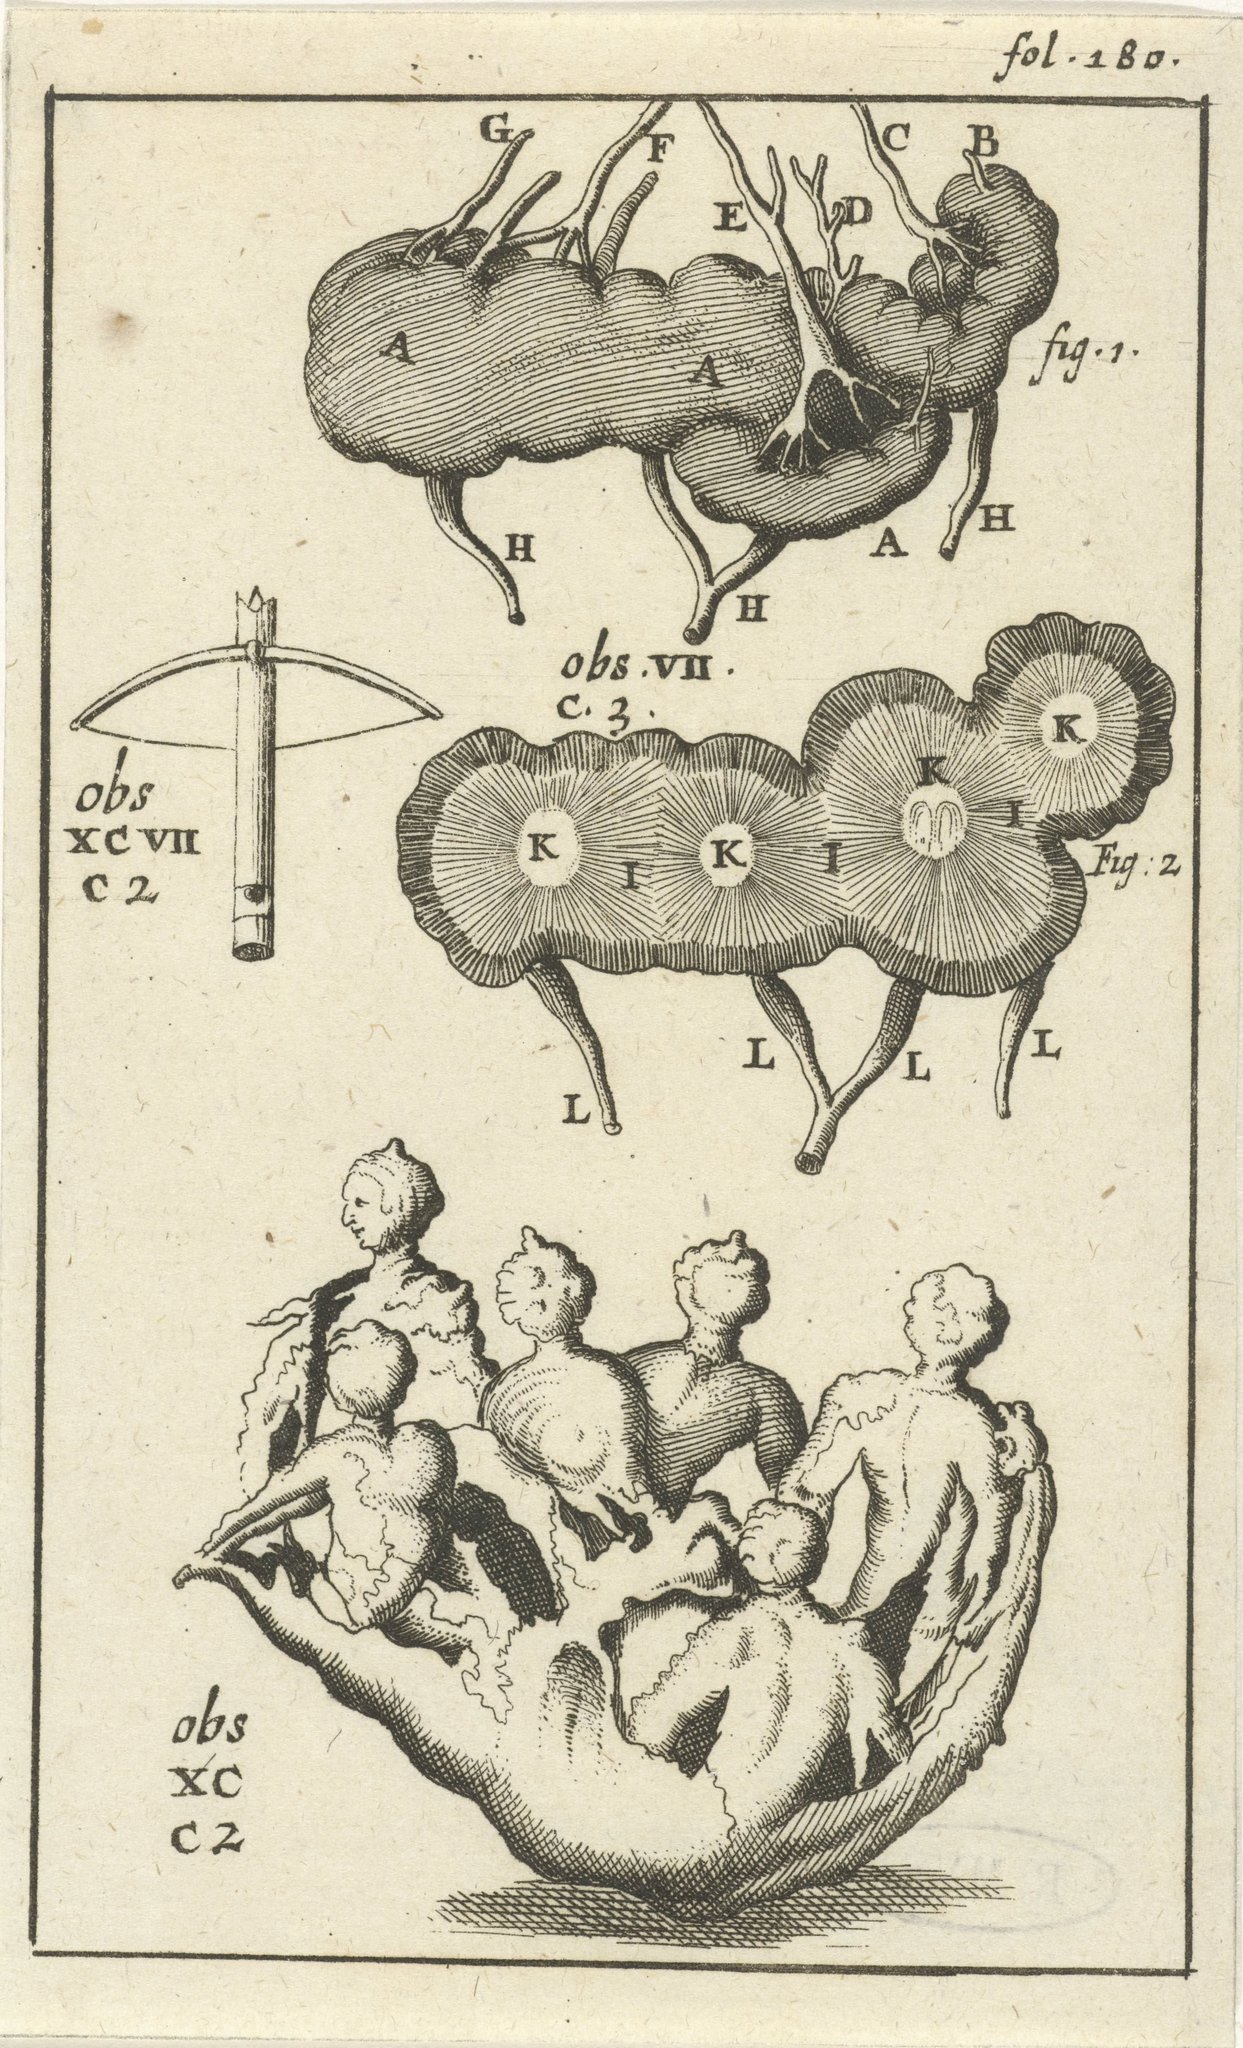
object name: book illustration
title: Anatomische afbeelding VII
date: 1680-1688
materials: paper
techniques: etching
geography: amsterdam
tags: biology, anatomical models (usually series of five figures)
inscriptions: collector's mark: Lugt 2228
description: Illustratie opgenomen in: Blankaart, Steven. Collectanea medico-physica, oft Hollands jaar-register der genees- en natuur-kundige aanmerkingen, 3 delen, dl. I, fol. 180. Amsterdam: Jan Claesz ten Hoorn, 1680-1688.